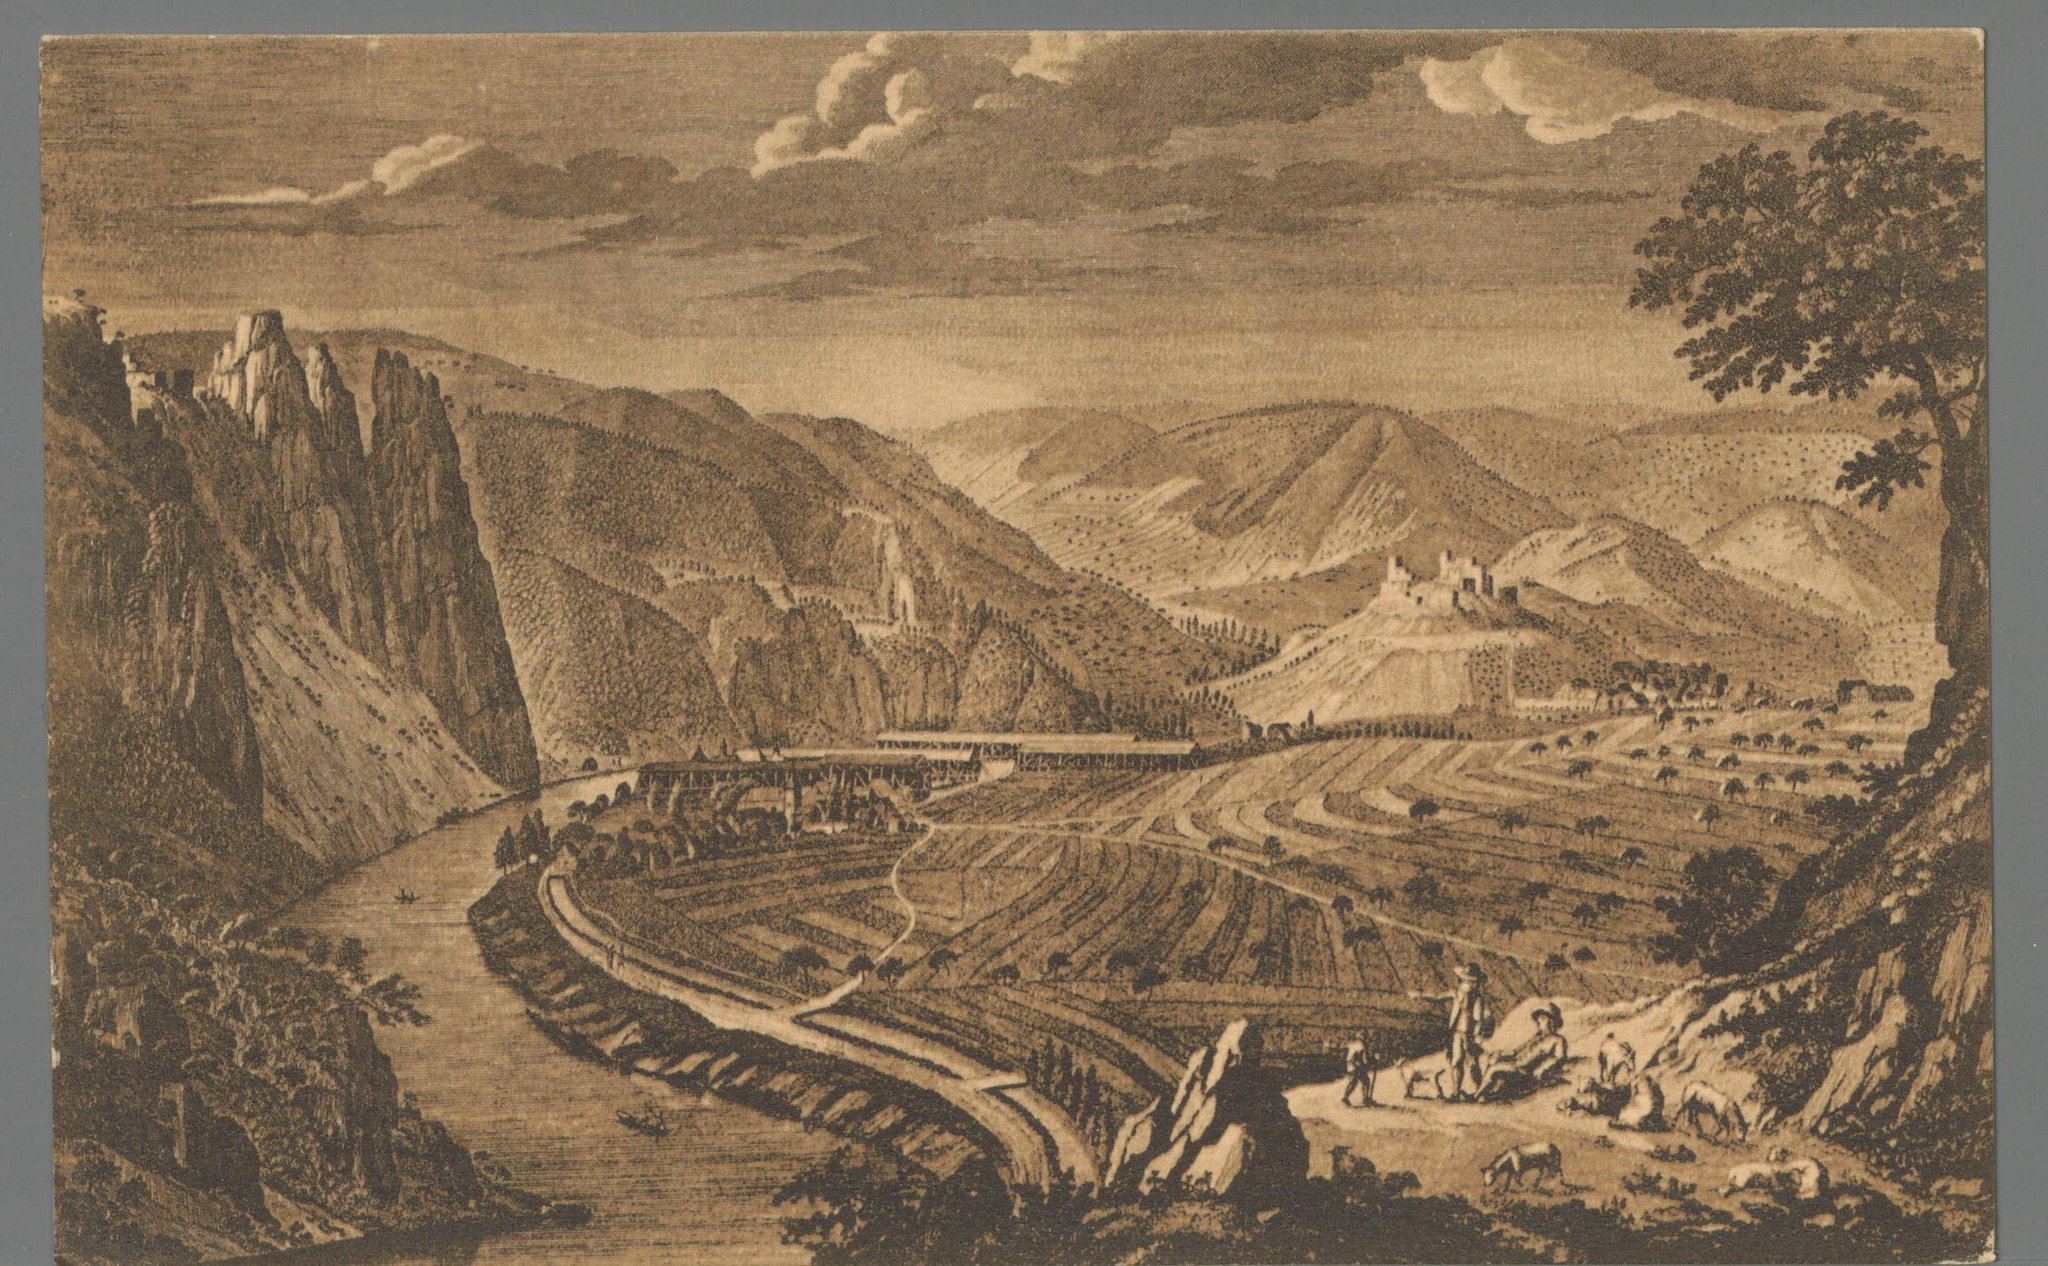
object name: reproduction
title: Saline bei Münster am Stein mit Rhein-grafenstein u. Ebernburg nach einem Stich aus dem Jahre 1790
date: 1907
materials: cardboard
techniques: photograph, writing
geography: mainz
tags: river, mountains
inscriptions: date